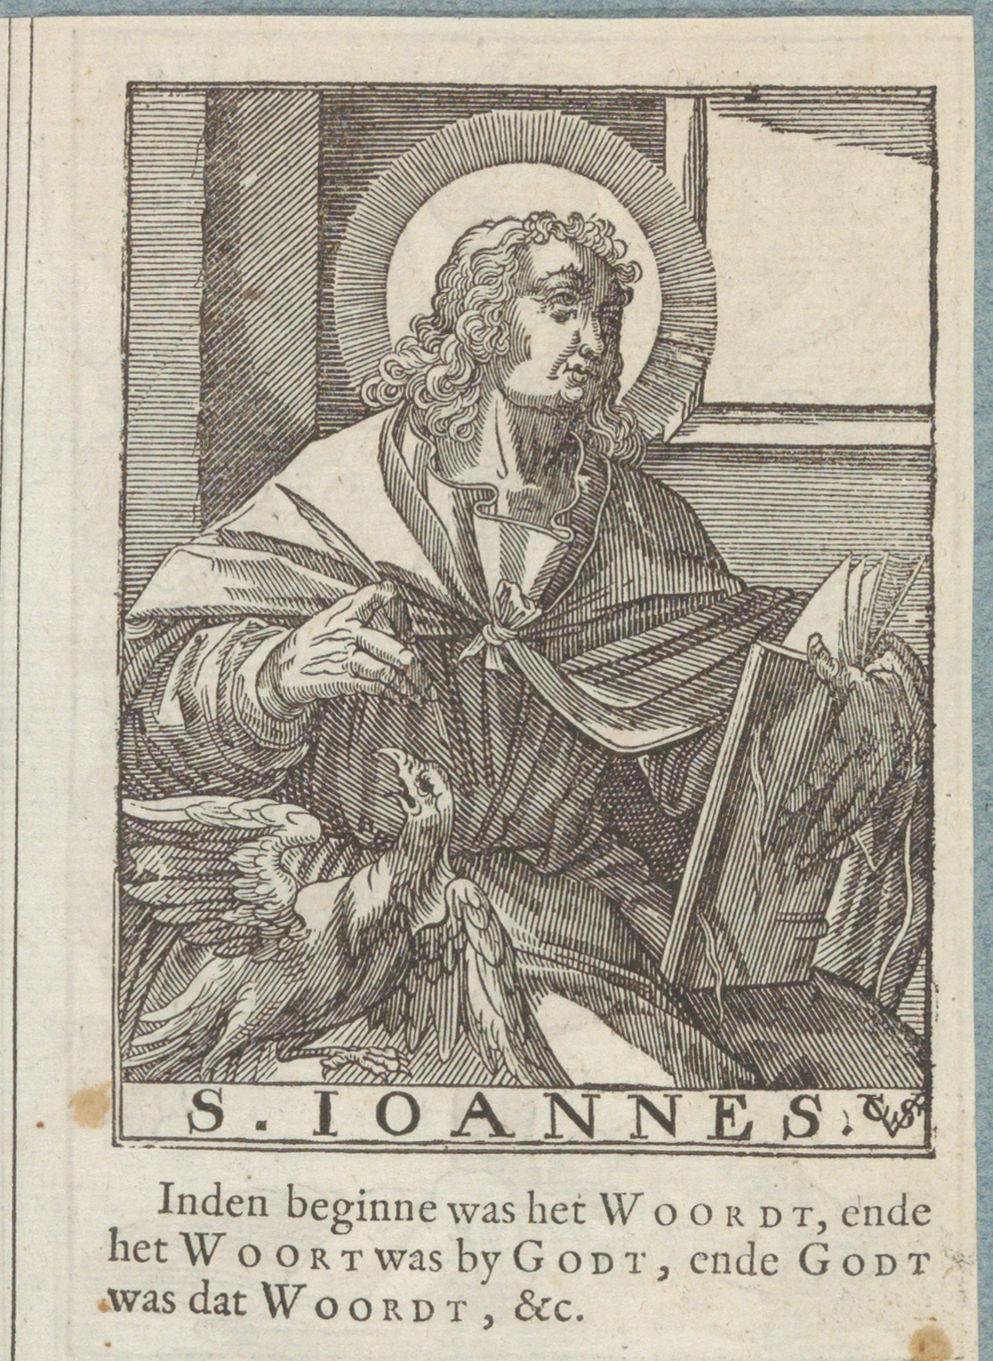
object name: album leaf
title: S. Ioannes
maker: pieter jacobsz. paets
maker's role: publisher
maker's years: 1587-1667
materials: paper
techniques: letterpress printing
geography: amsterdam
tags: the apostle john the evangelist; possible attributes: book, cauldron, chalice with snake, eagle, palm, scroll, eagle (possibly with book) ~ symbol of st. john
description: De prent is afkomstig uit een van de uitgaven van P.J. Paets uit Amsterdam. Ze komt in ieder geval voor in: 'tSchat der Zielen. Amsterdam, P.J. Paets, 1648.